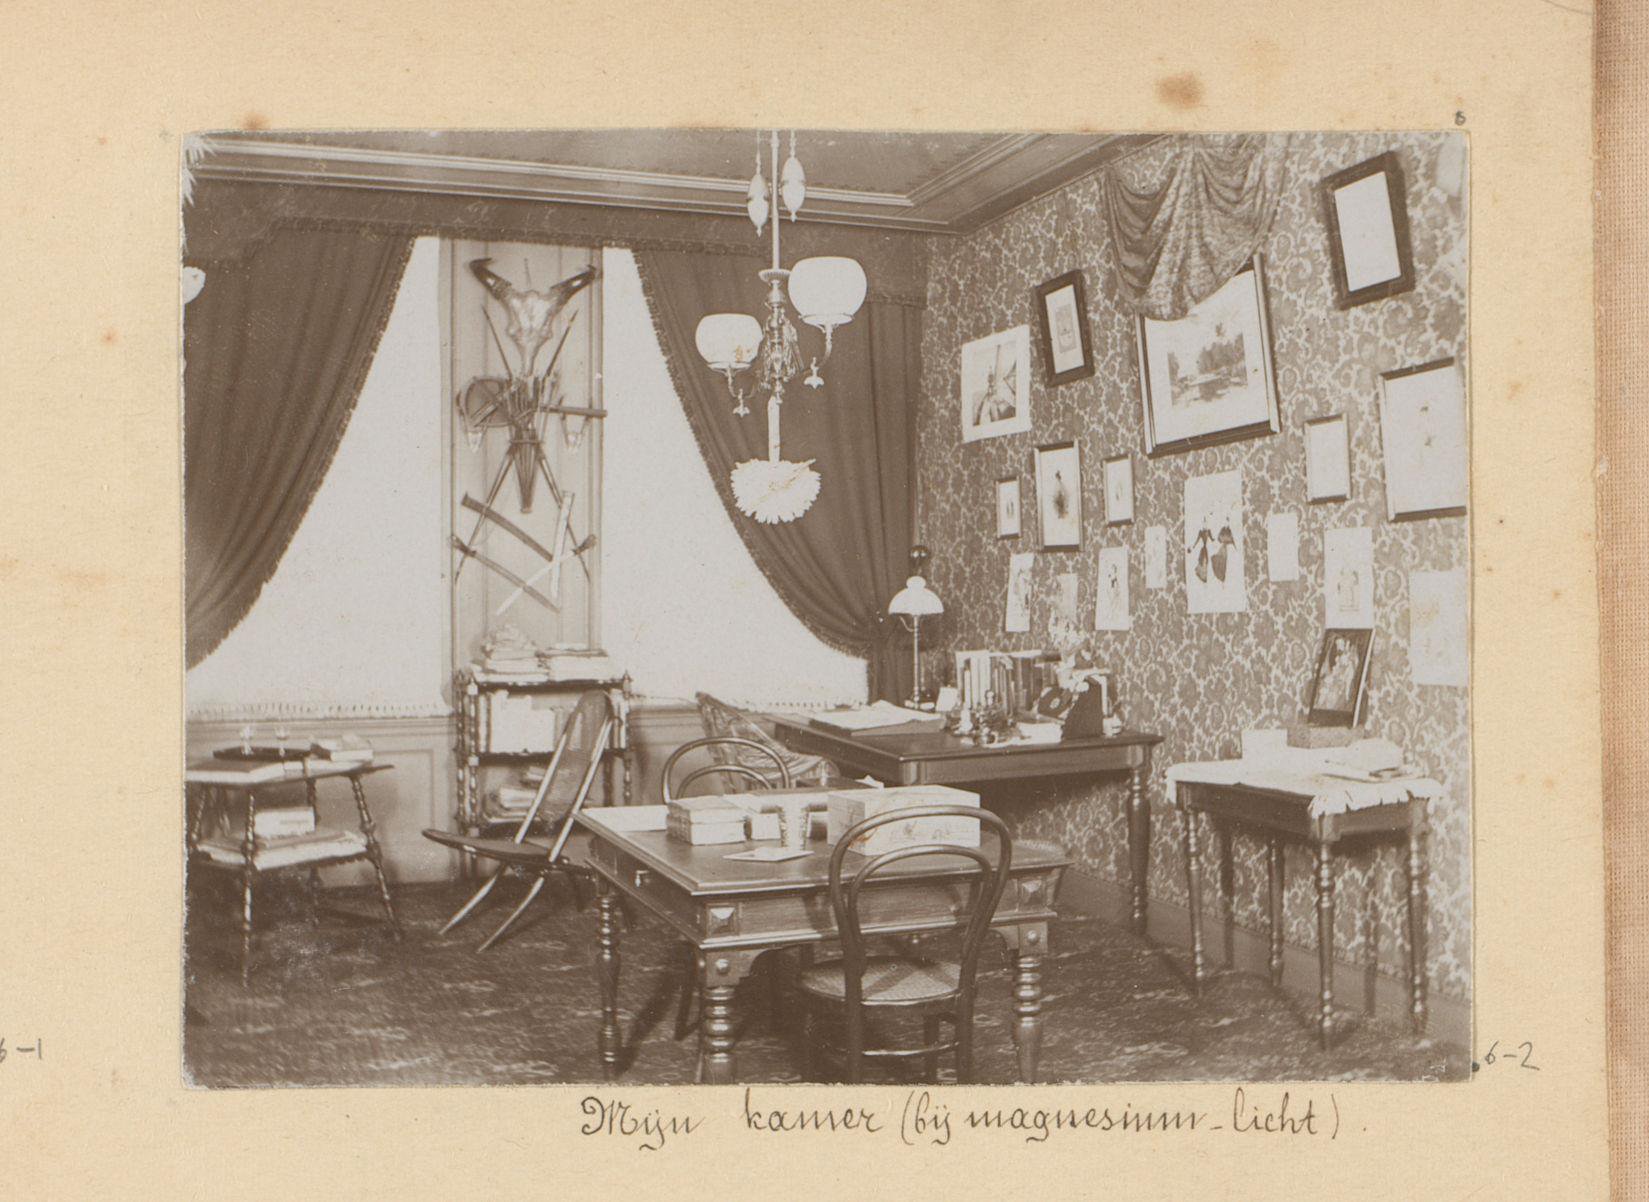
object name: photograph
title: Mijn kamer (bij magnesiumlicht)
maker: hendrik herman van den berg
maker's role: amateurfotograaf, jurist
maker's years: 1875-1944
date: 1890-1894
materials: paper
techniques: collodion silver print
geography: amsterdam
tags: interior ~ representation of a building, amsterdam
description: De foto is gemaakt bij flitslicht afkomstig van bliksempoeder.